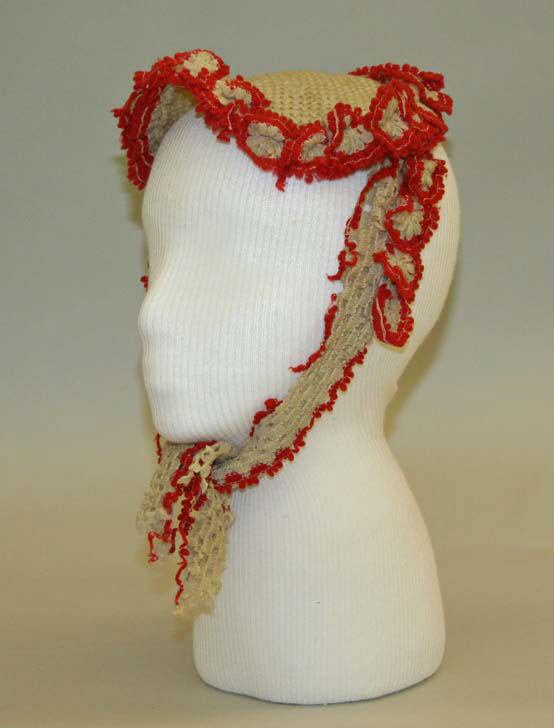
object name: cap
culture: american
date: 1858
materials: wool